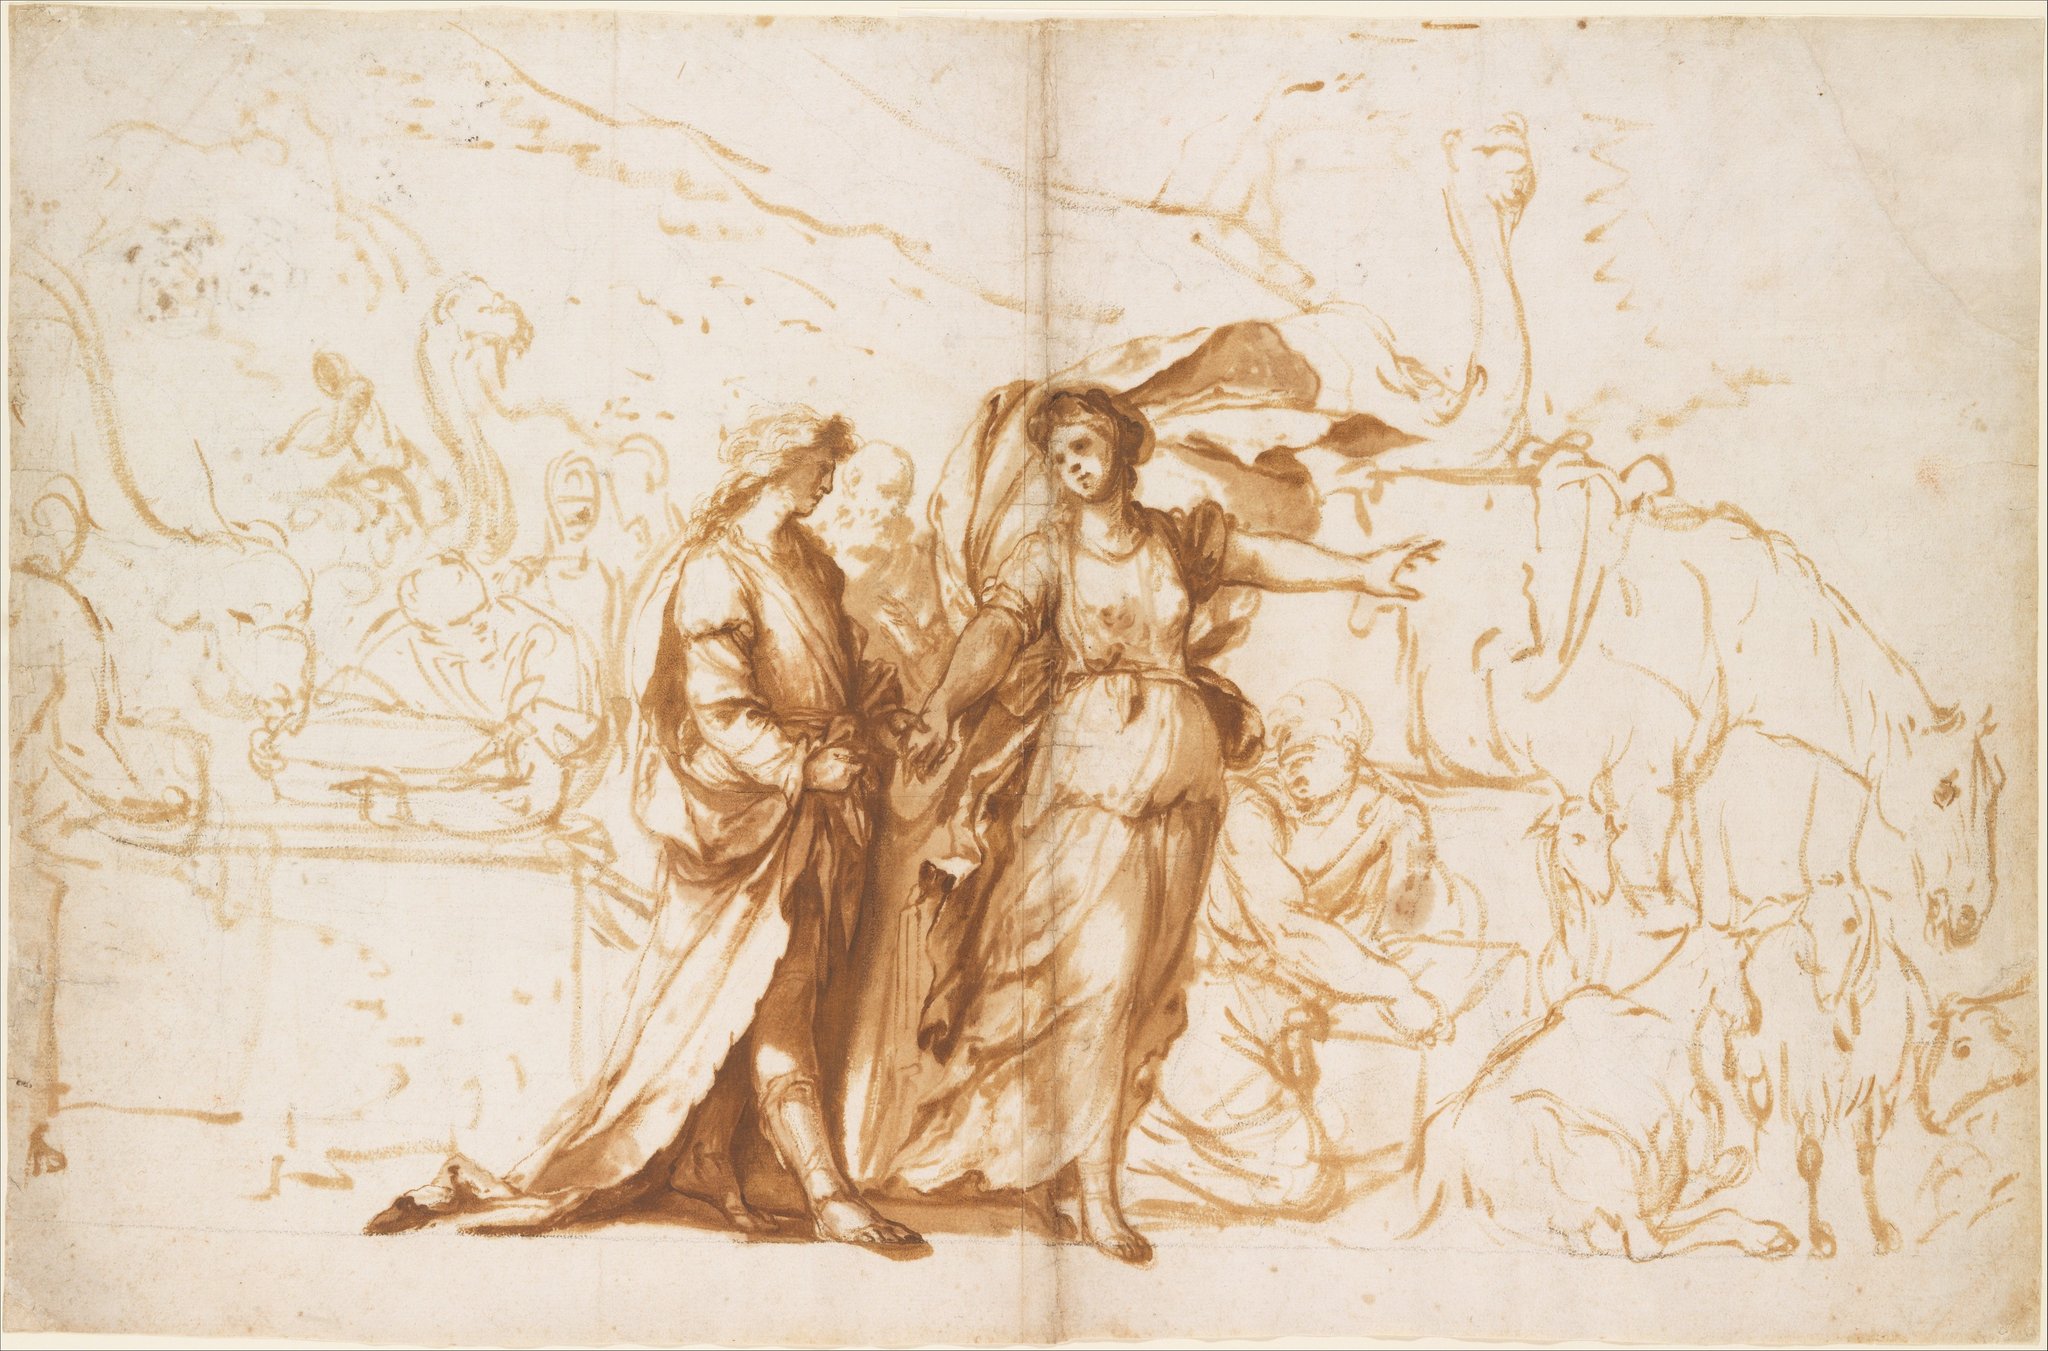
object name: drawing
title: Rebecca at the Well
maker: giovanni benedetto castiglione (il grechetto)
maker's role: artist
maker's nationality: italian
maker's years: 1609-1664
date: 1601-1700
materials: chalk, ink, paper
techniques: brush, wash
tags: women,camels,horses